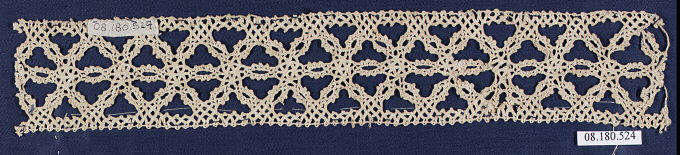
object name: insertion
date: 1501-1600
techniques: lace